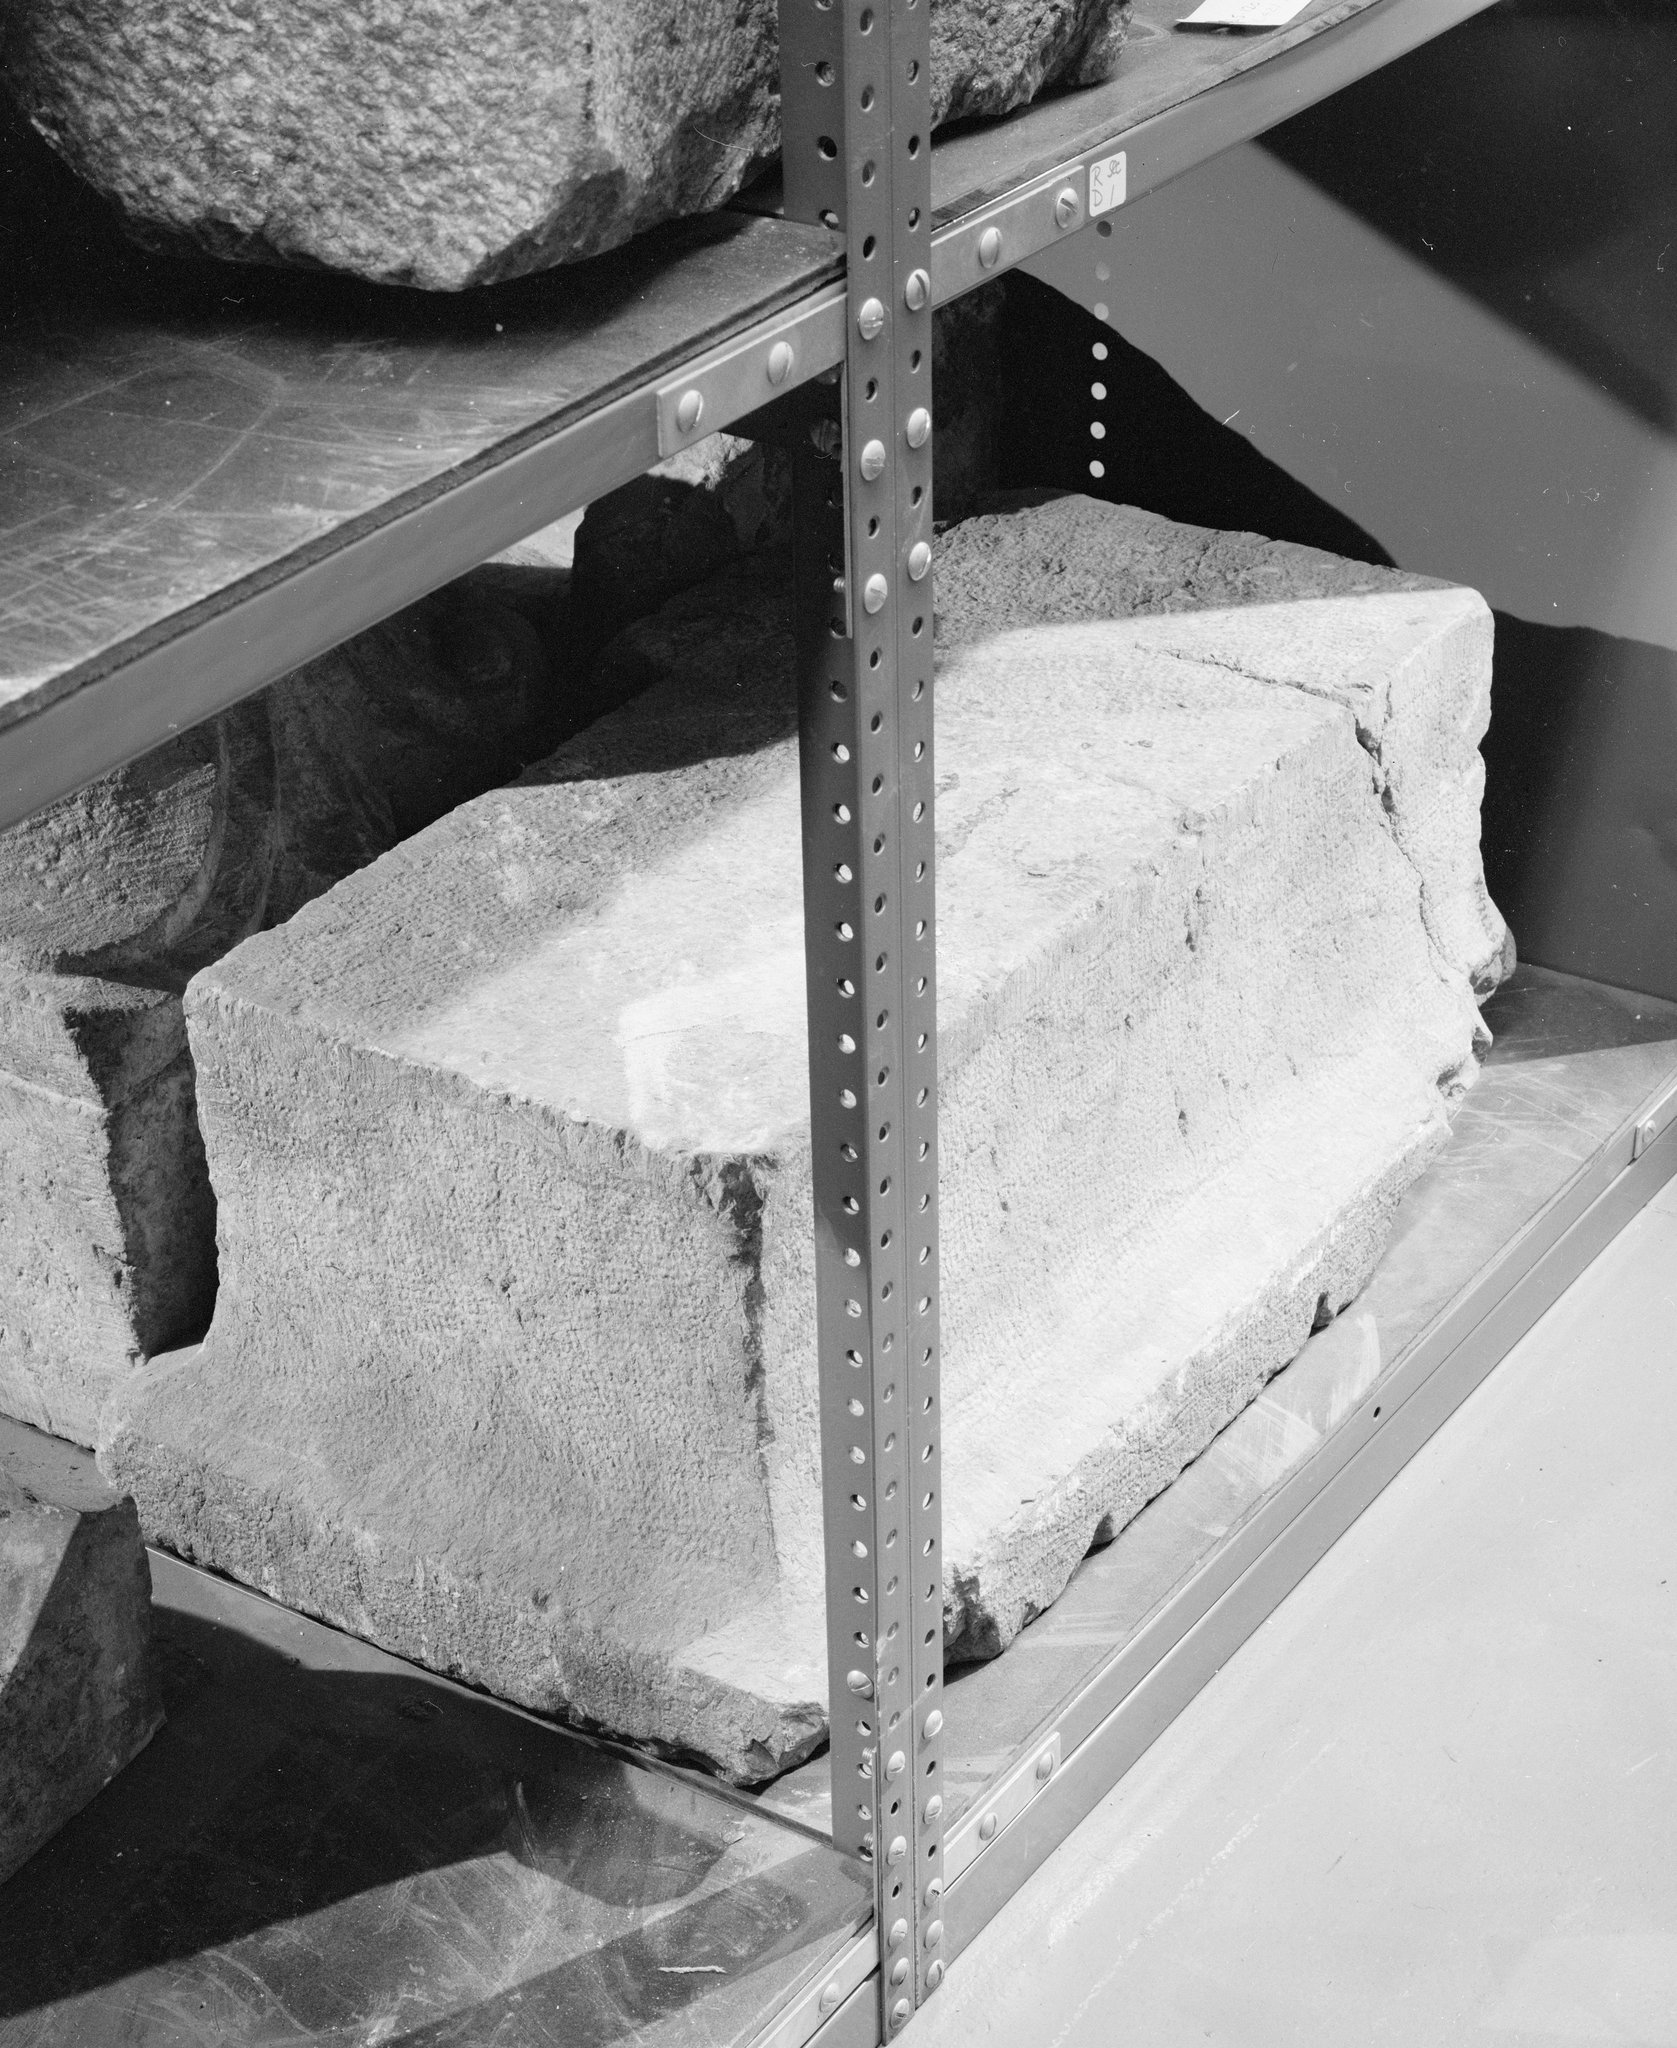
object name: base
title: Pier Base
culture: french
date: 1130-1140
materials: stone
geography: france